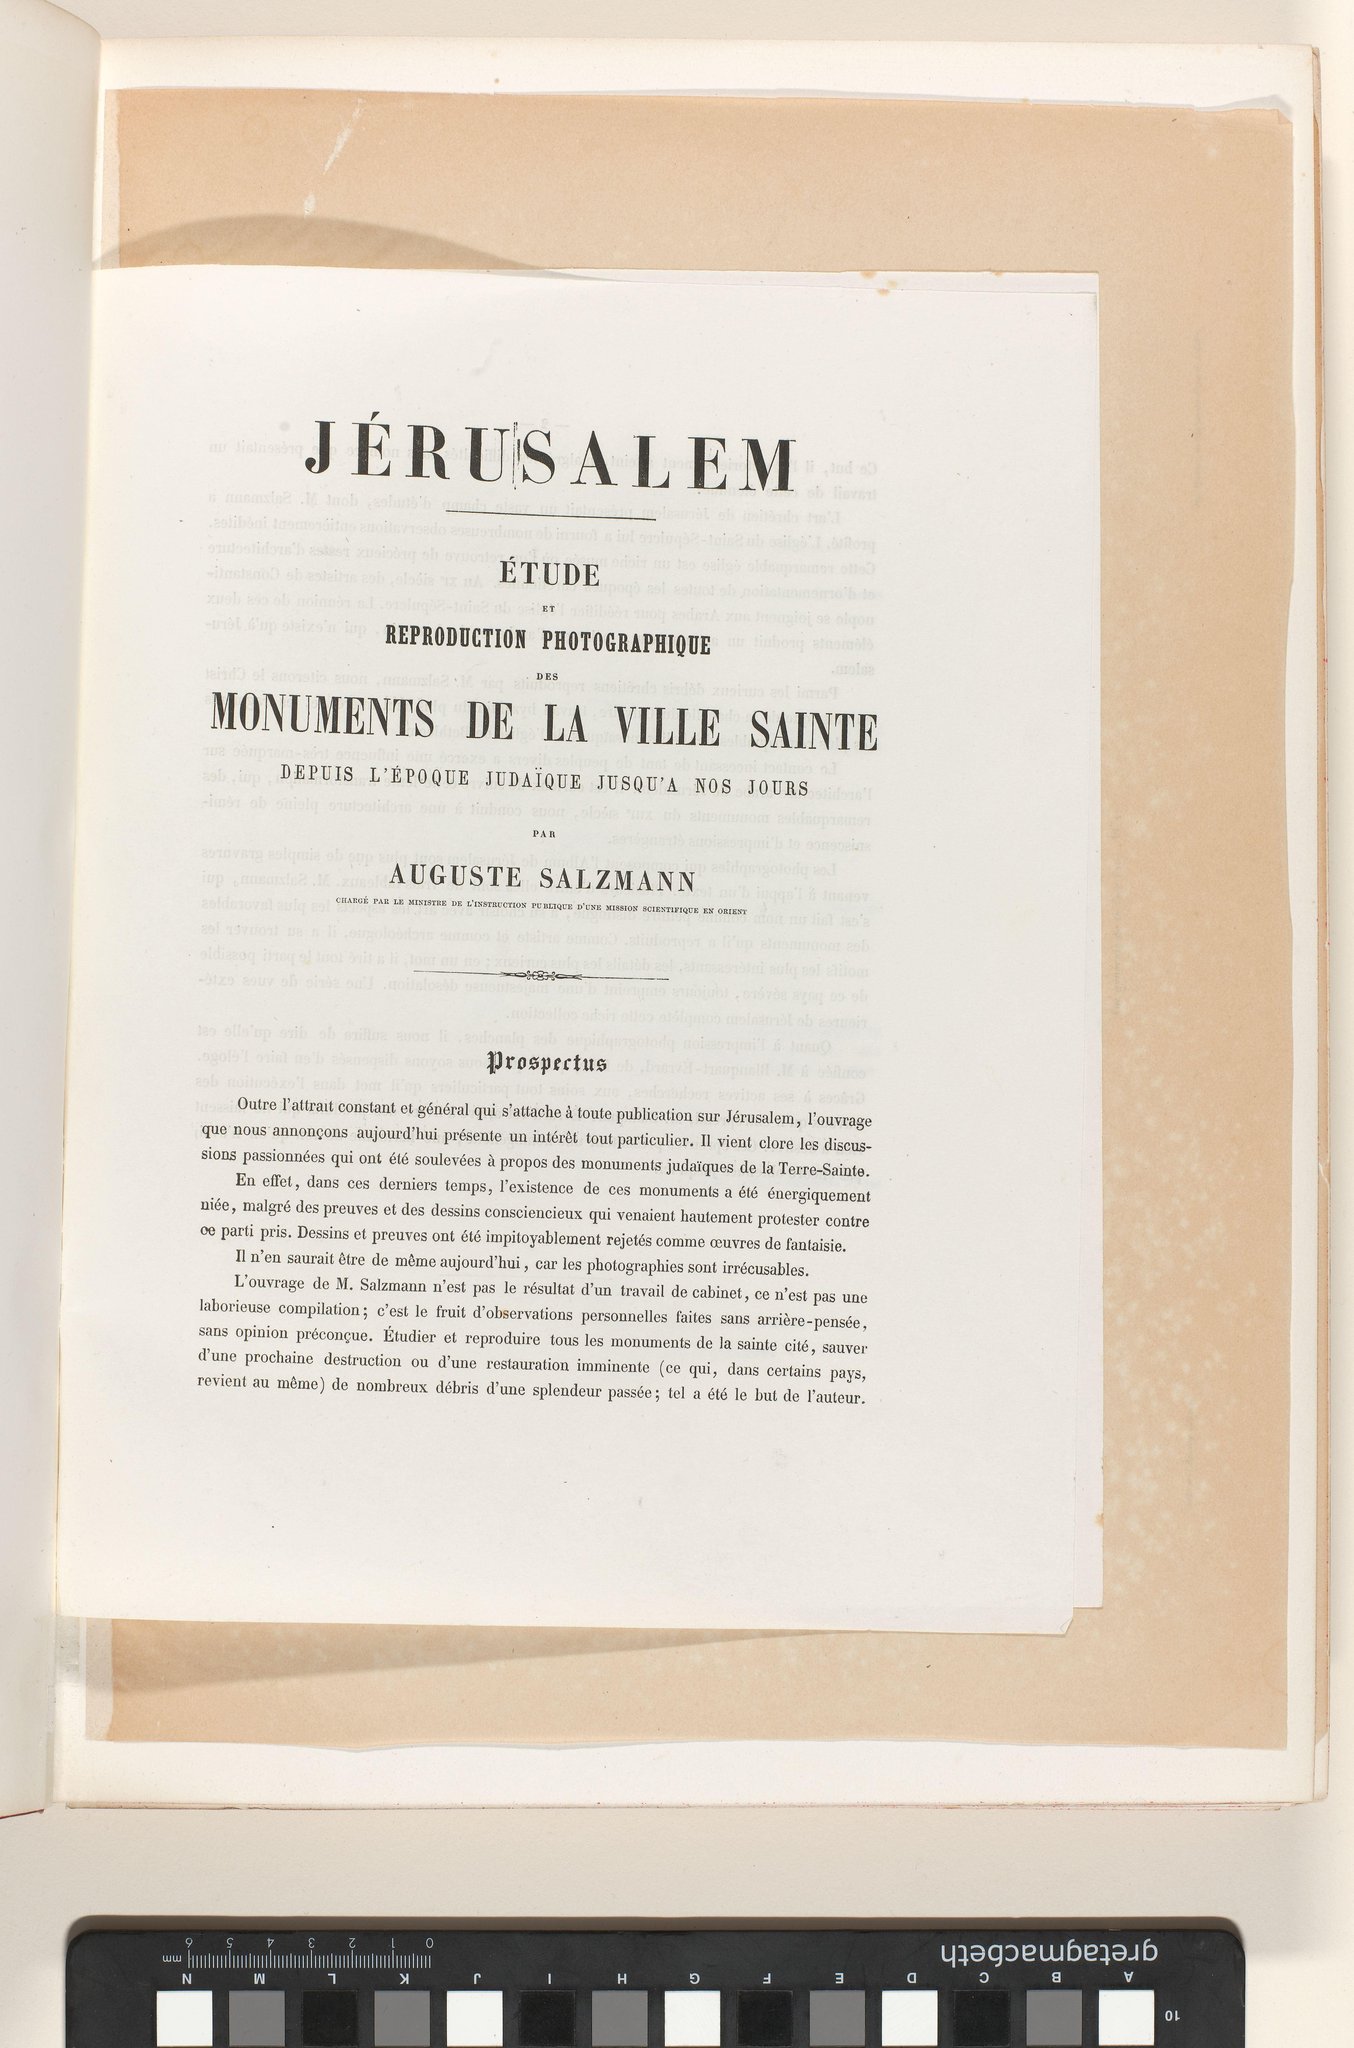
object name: photograph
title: Gezicht op Jeruzalem, met de ommuring van de tempel en de Rotskoepel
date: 1854-1856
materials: cardboard, paper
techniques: salted paper print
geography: jerusalem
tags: city-view in general; 'veduta', fence, wall, paling, temple, shrine ~ islam, mohammedanism